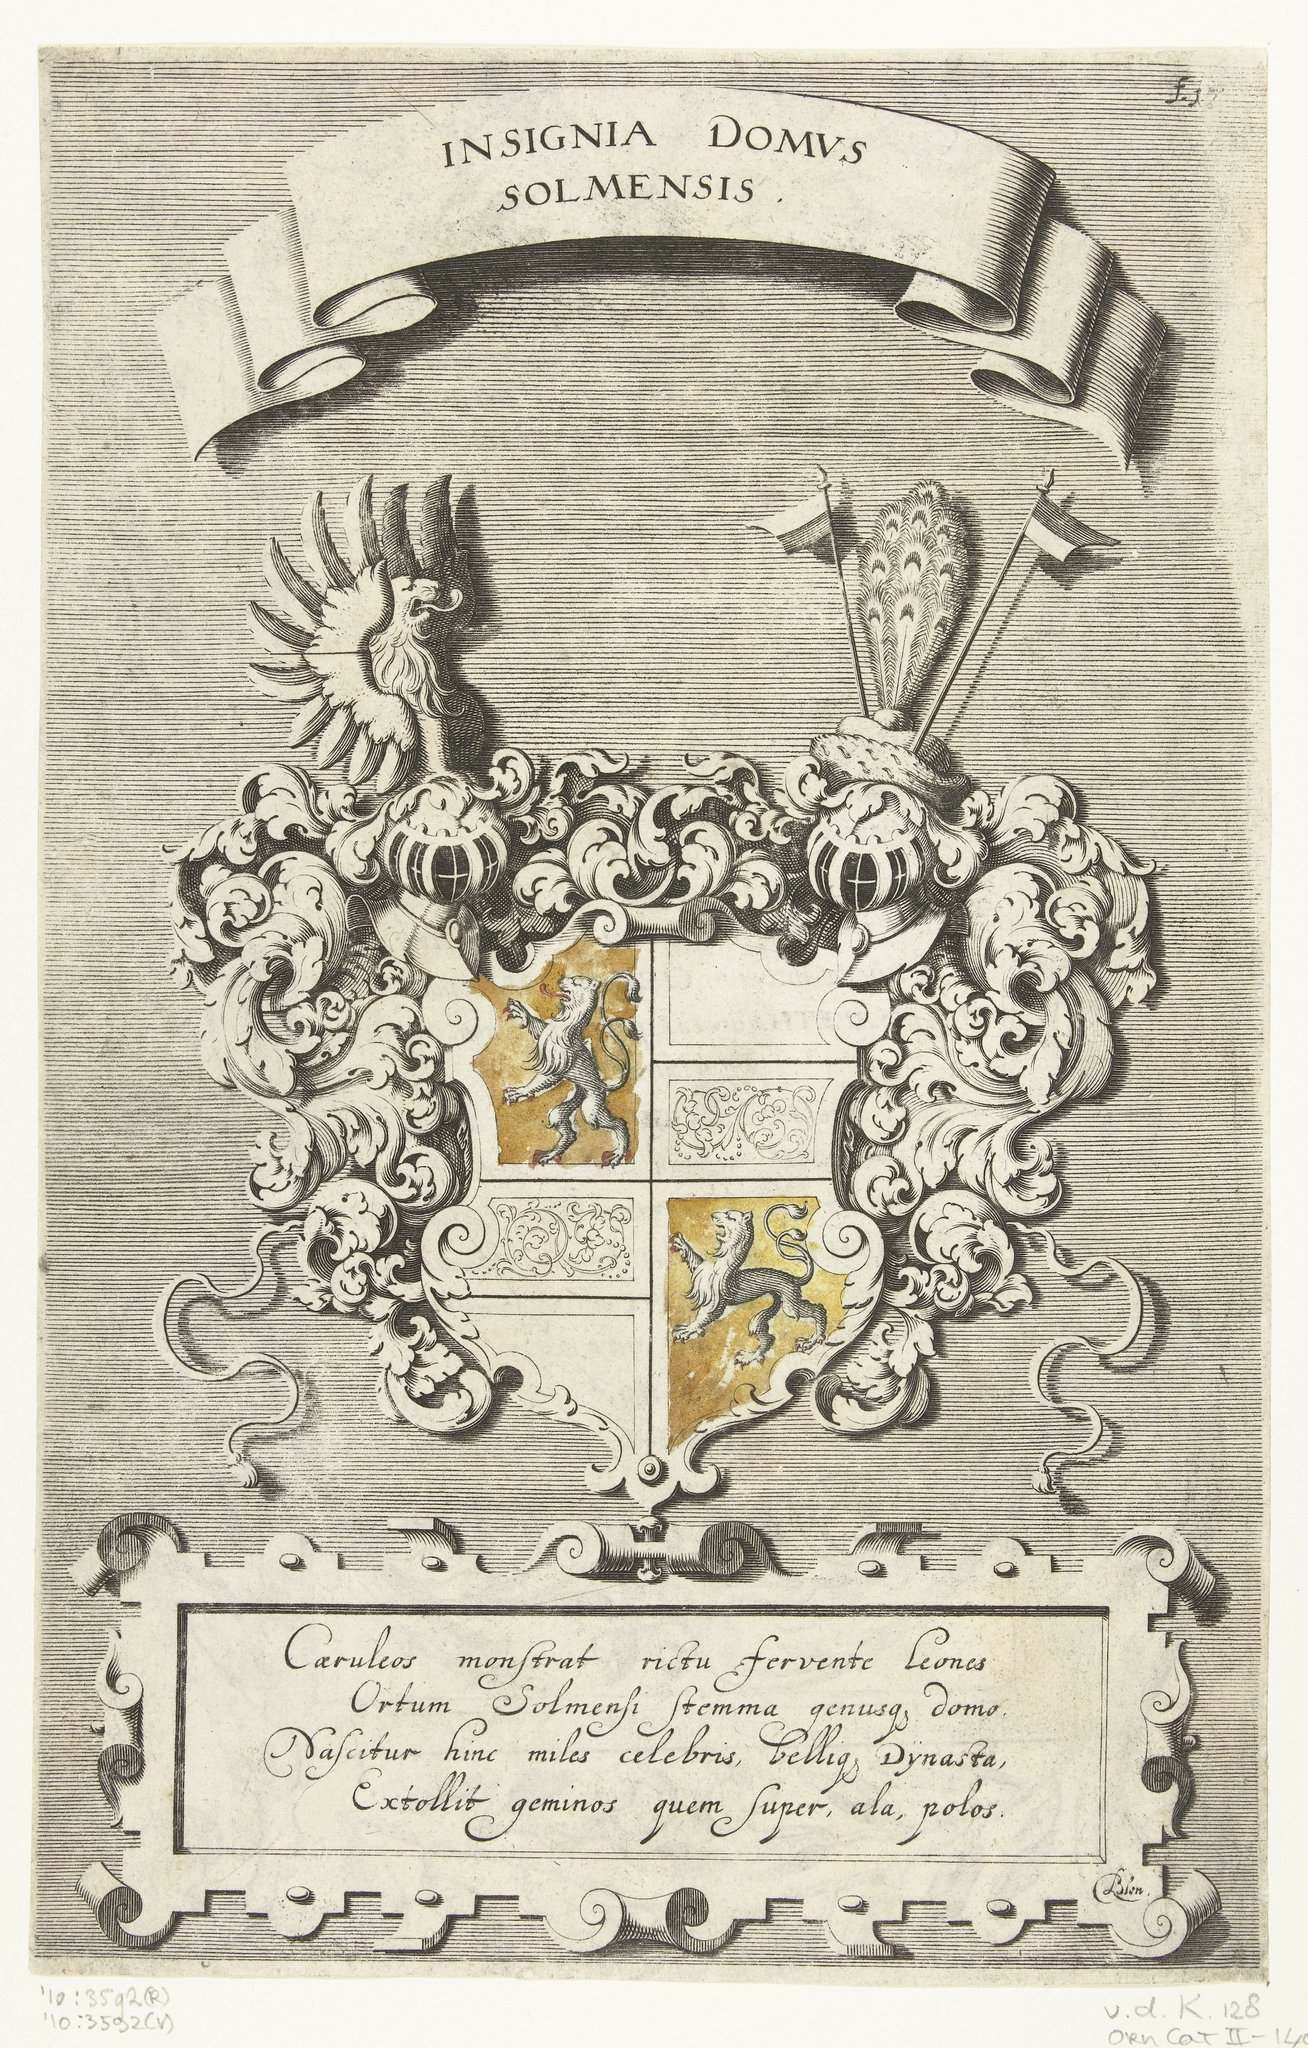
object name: print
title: Monumentum Sepulcrale, ad Illustrissimi Celsissimique Principis ac Domin (...)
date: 1628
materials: paper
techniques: engraving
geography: frankfurt am main